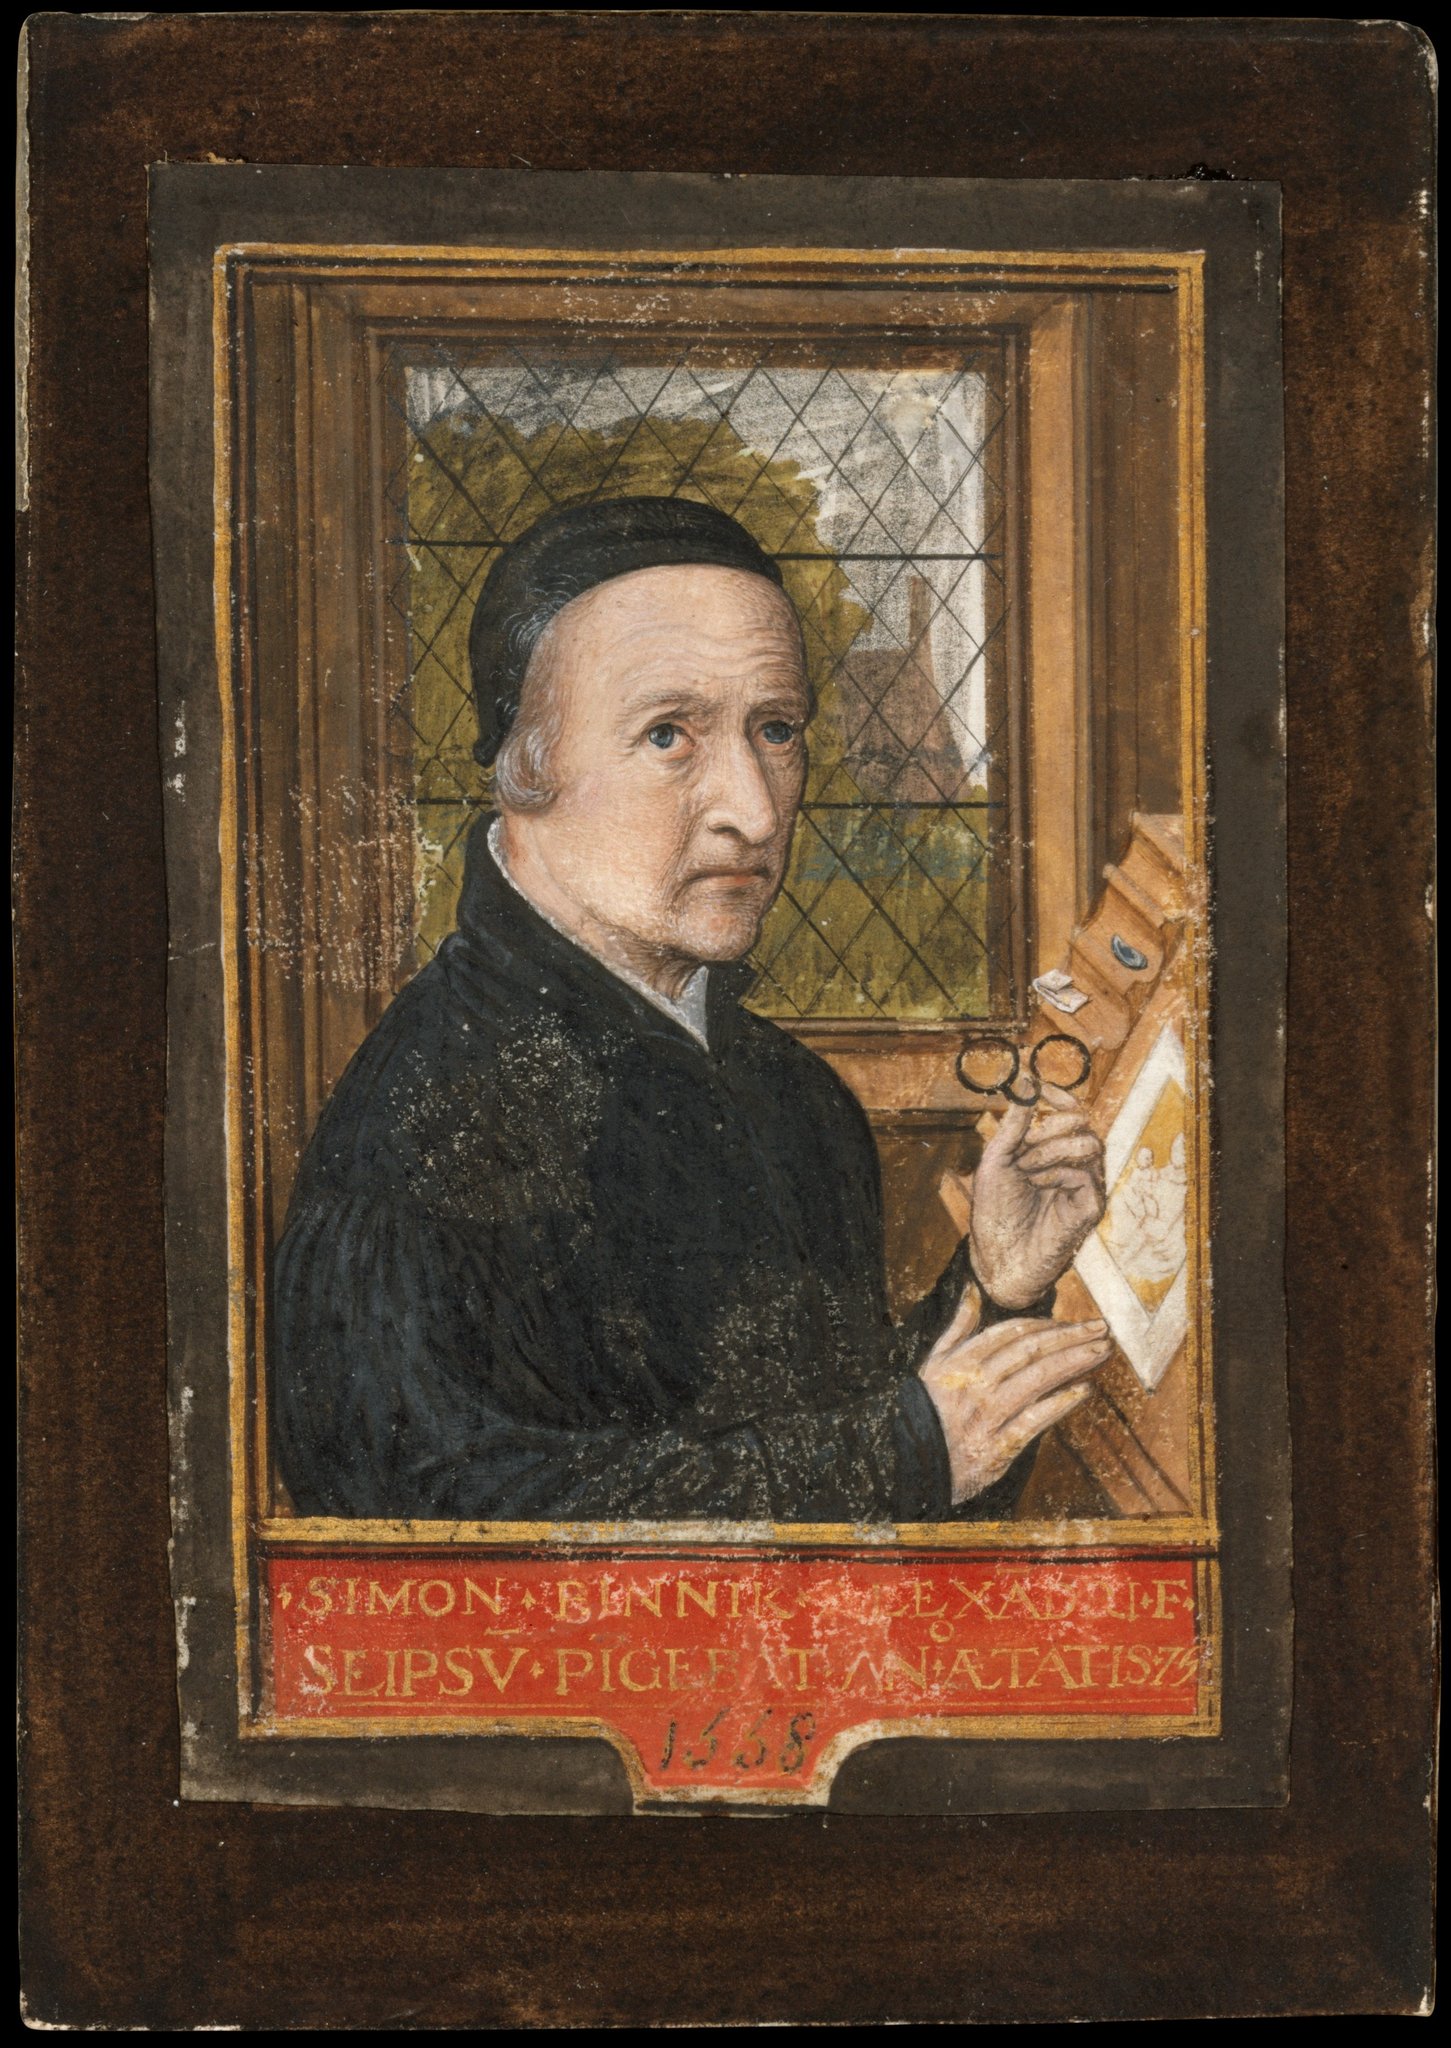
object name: manuscript and illumination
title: Self-portrait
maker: simon bening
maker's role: artist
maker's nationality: netherlandish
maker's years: 1483-1561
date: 1558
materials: gold leaf, parchment, paint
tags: men,self-portraits